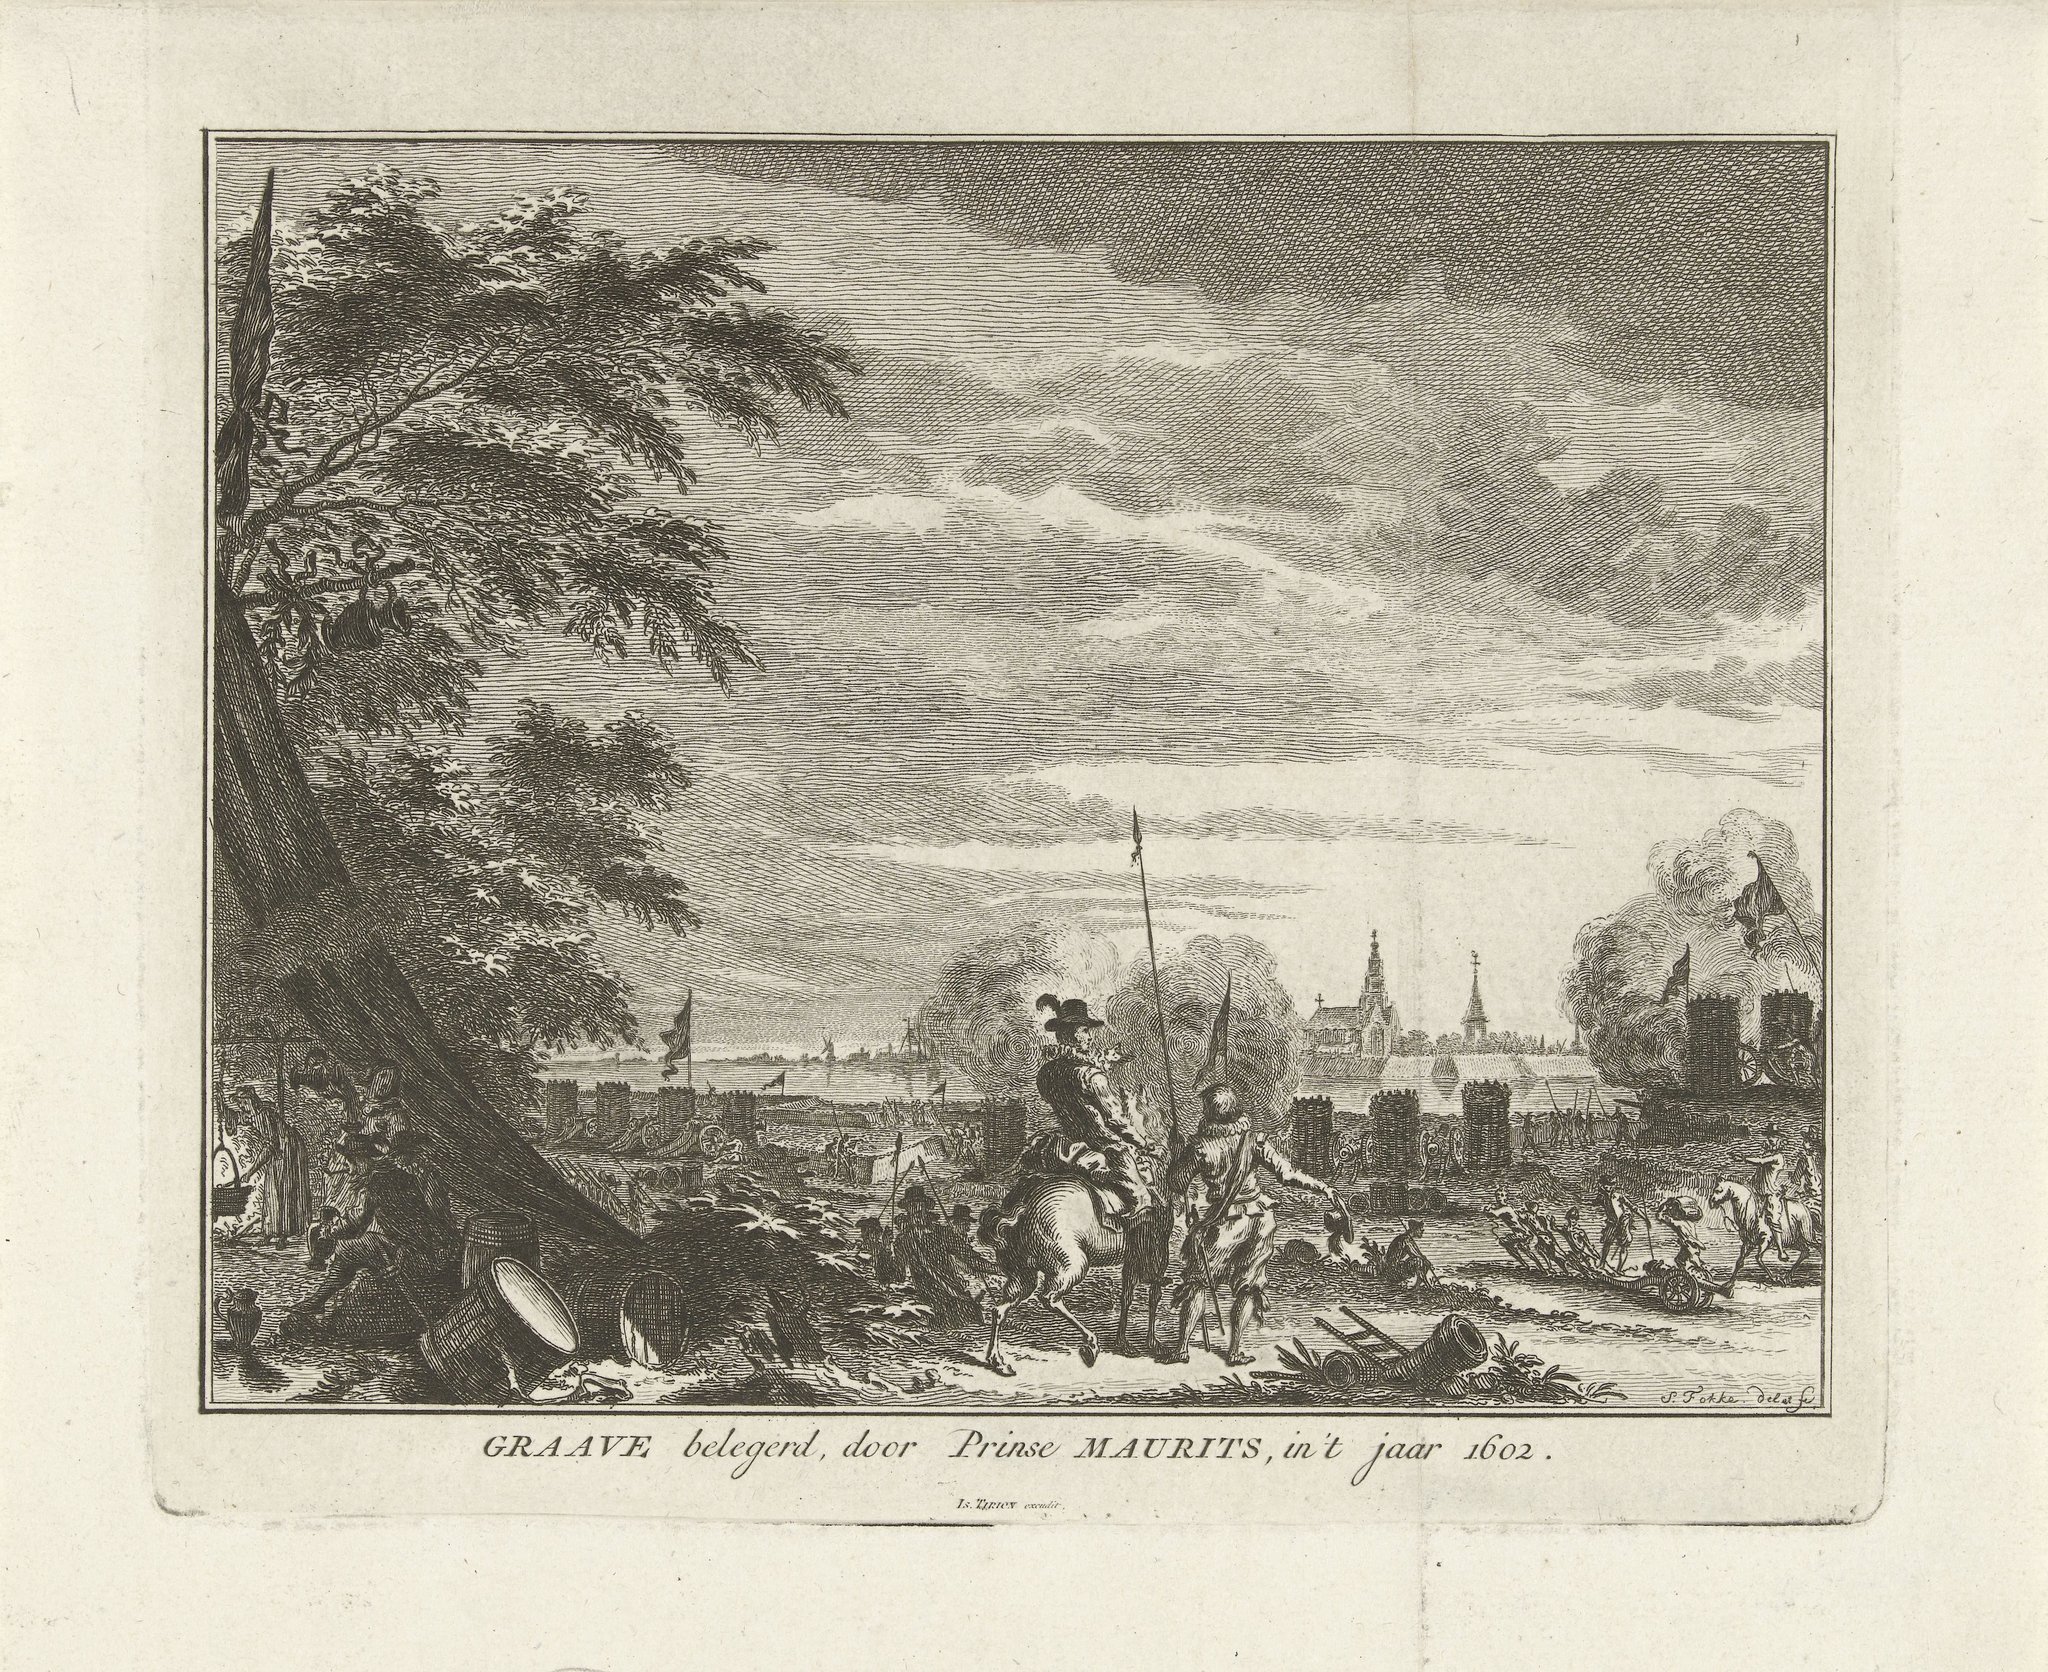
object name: print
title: Beleg van Grave door Maurits, 1602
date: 1756-1758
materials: paper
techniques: etching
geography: northern netherlands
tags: the hague, maurice (prince of orange), siege, position war, grave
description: De stad Grave, belegerd en veroverd door het Staatse leger onder prins Maurits, 18 juli - 20 september 1602. De prins te paard in het legerkamp, in de verte het profiel van de stad.